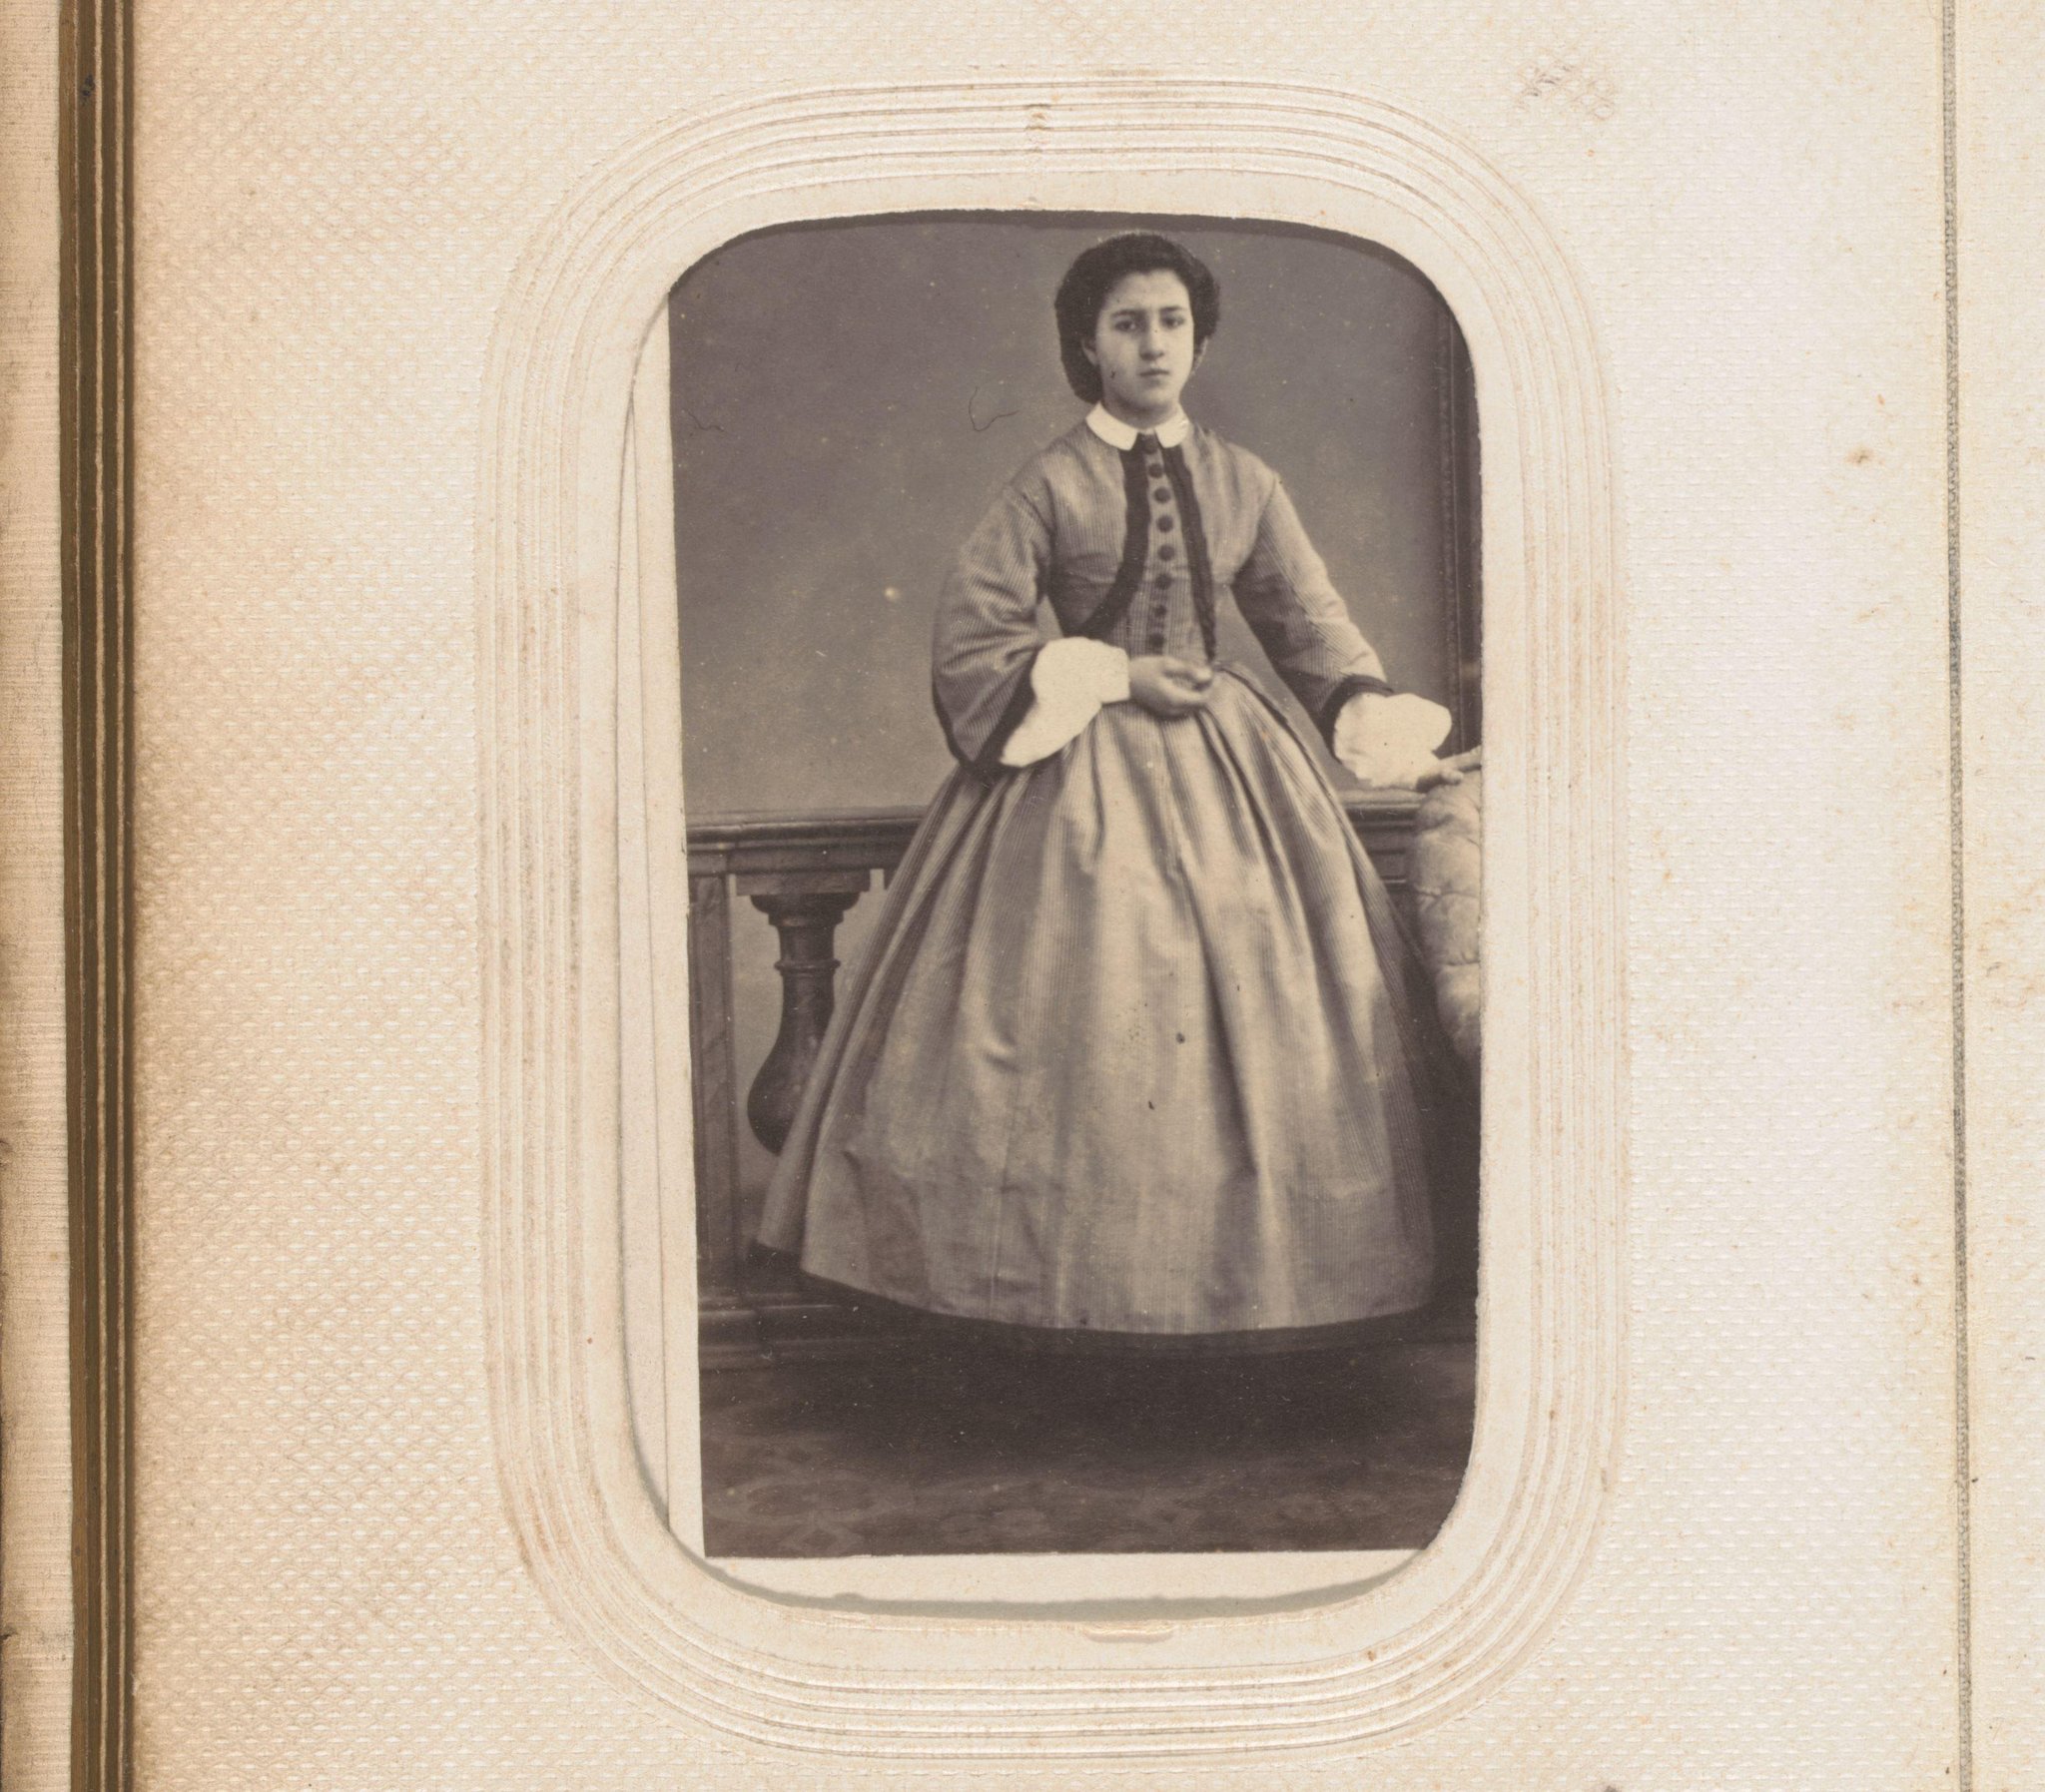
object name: carte de visite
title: Portret van een staand meisje bij een balustrade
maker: Anonymous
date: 1855-1865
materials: cardboard, photographic support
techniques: albumen print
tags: historical persons, girl (child between toddler and youth), balustrade